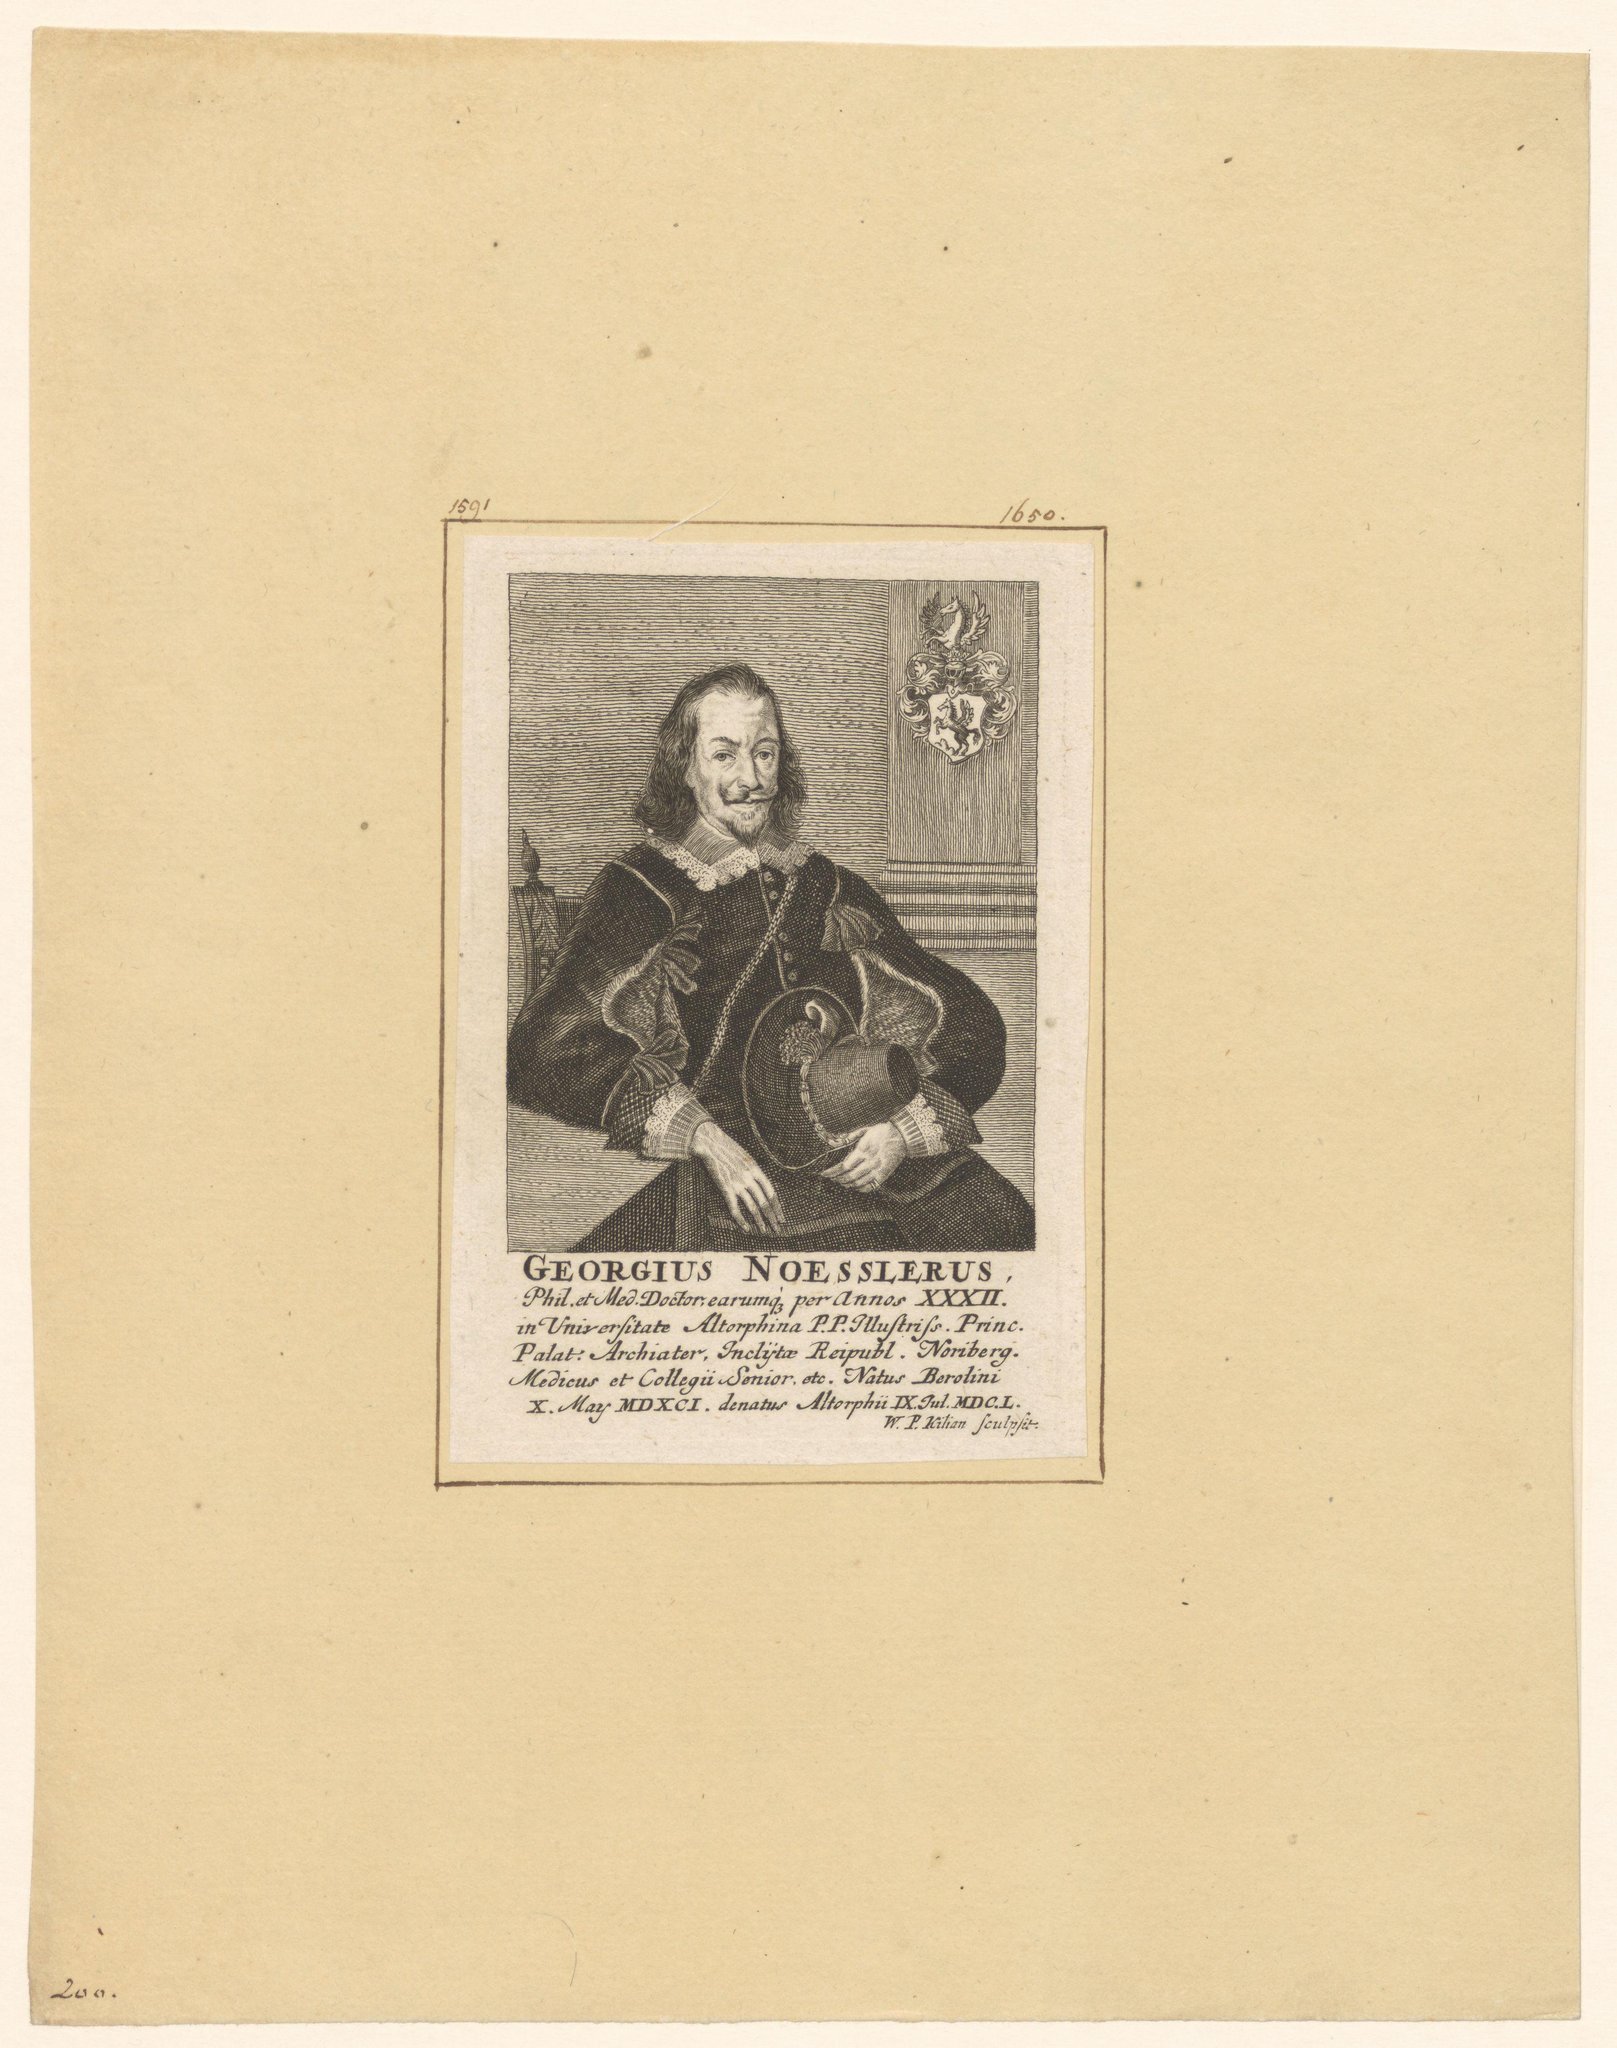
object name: print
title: Portret van Georg Nößler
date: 1669-1728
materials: paper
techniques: engraving, etching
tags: berlin, georg nössler, historical persons, physician, doctor (+ portrait of scholar, scientist)